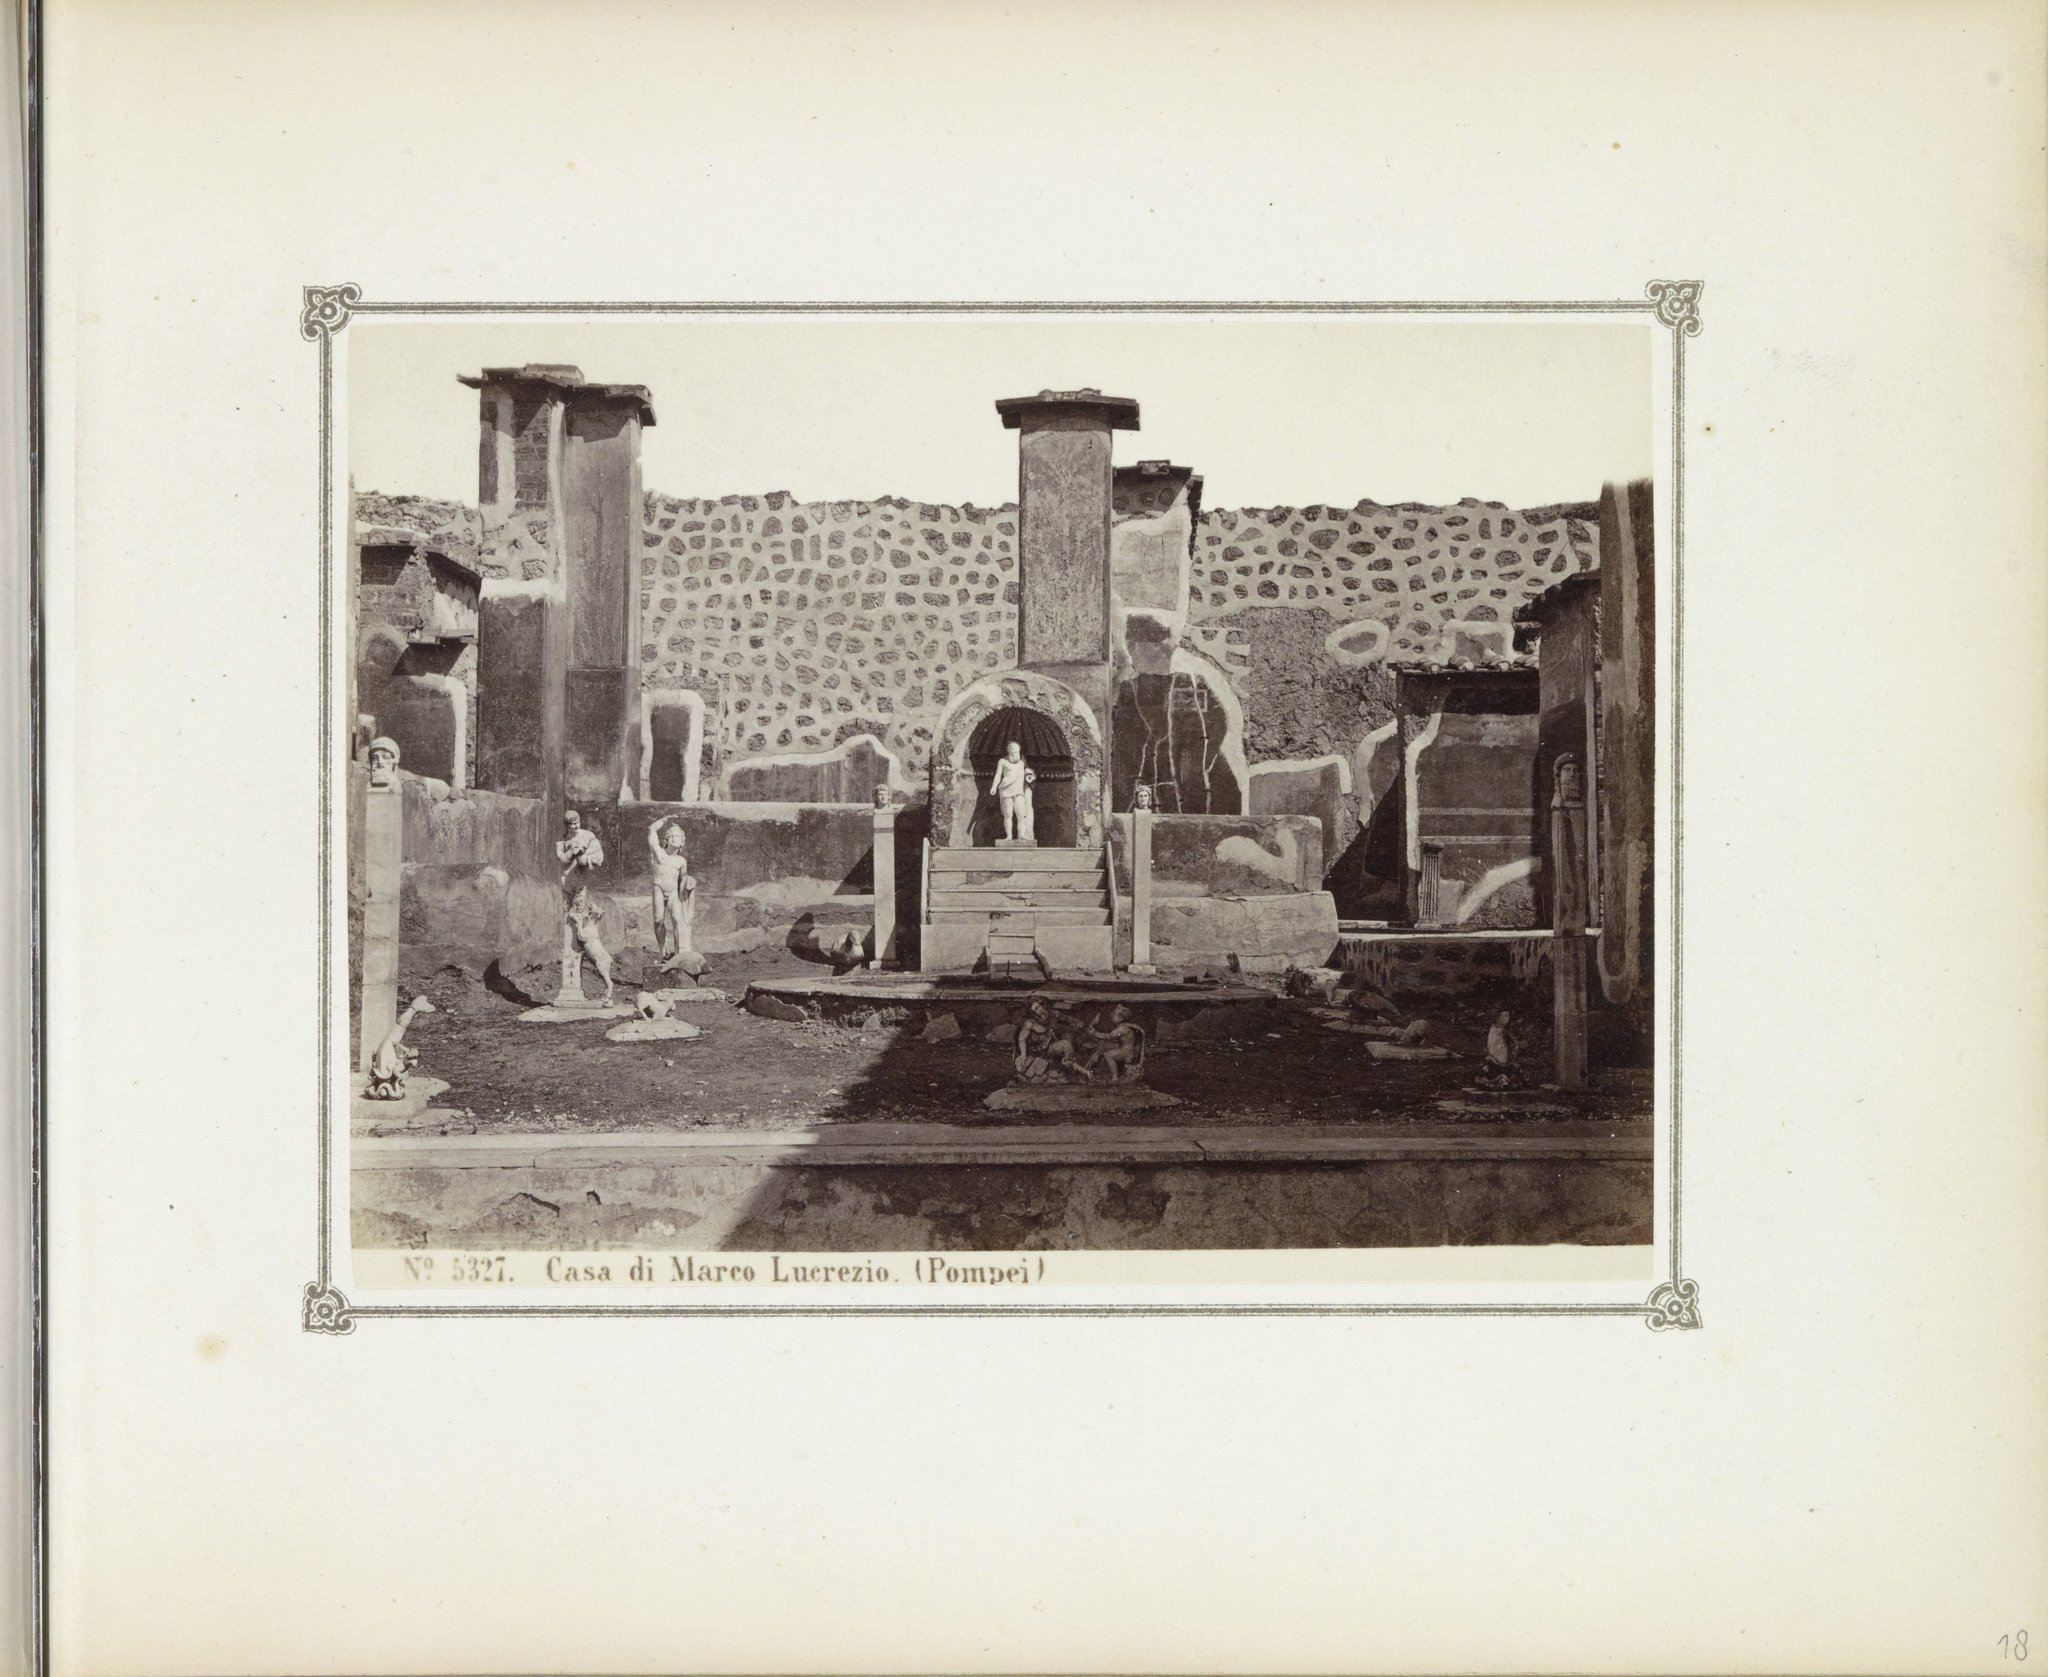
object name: album leaf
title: Casa di Marco Lucrezio (Pompei)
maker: giorgio sommer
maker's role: fotograaf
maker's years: 1834-1914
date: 1860-1900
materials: paper, photographic support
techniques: albumen print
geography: pompeii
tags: piece of sculpture, reproduction of a piece of sculpture (+ sculpture), villa, excavation ~ archaeology, pompeii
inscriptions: number: ‘5327’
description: Onderdeel van Fotoalbum met opnames van opgravingen in Pompeï door Giorgio Sommer.